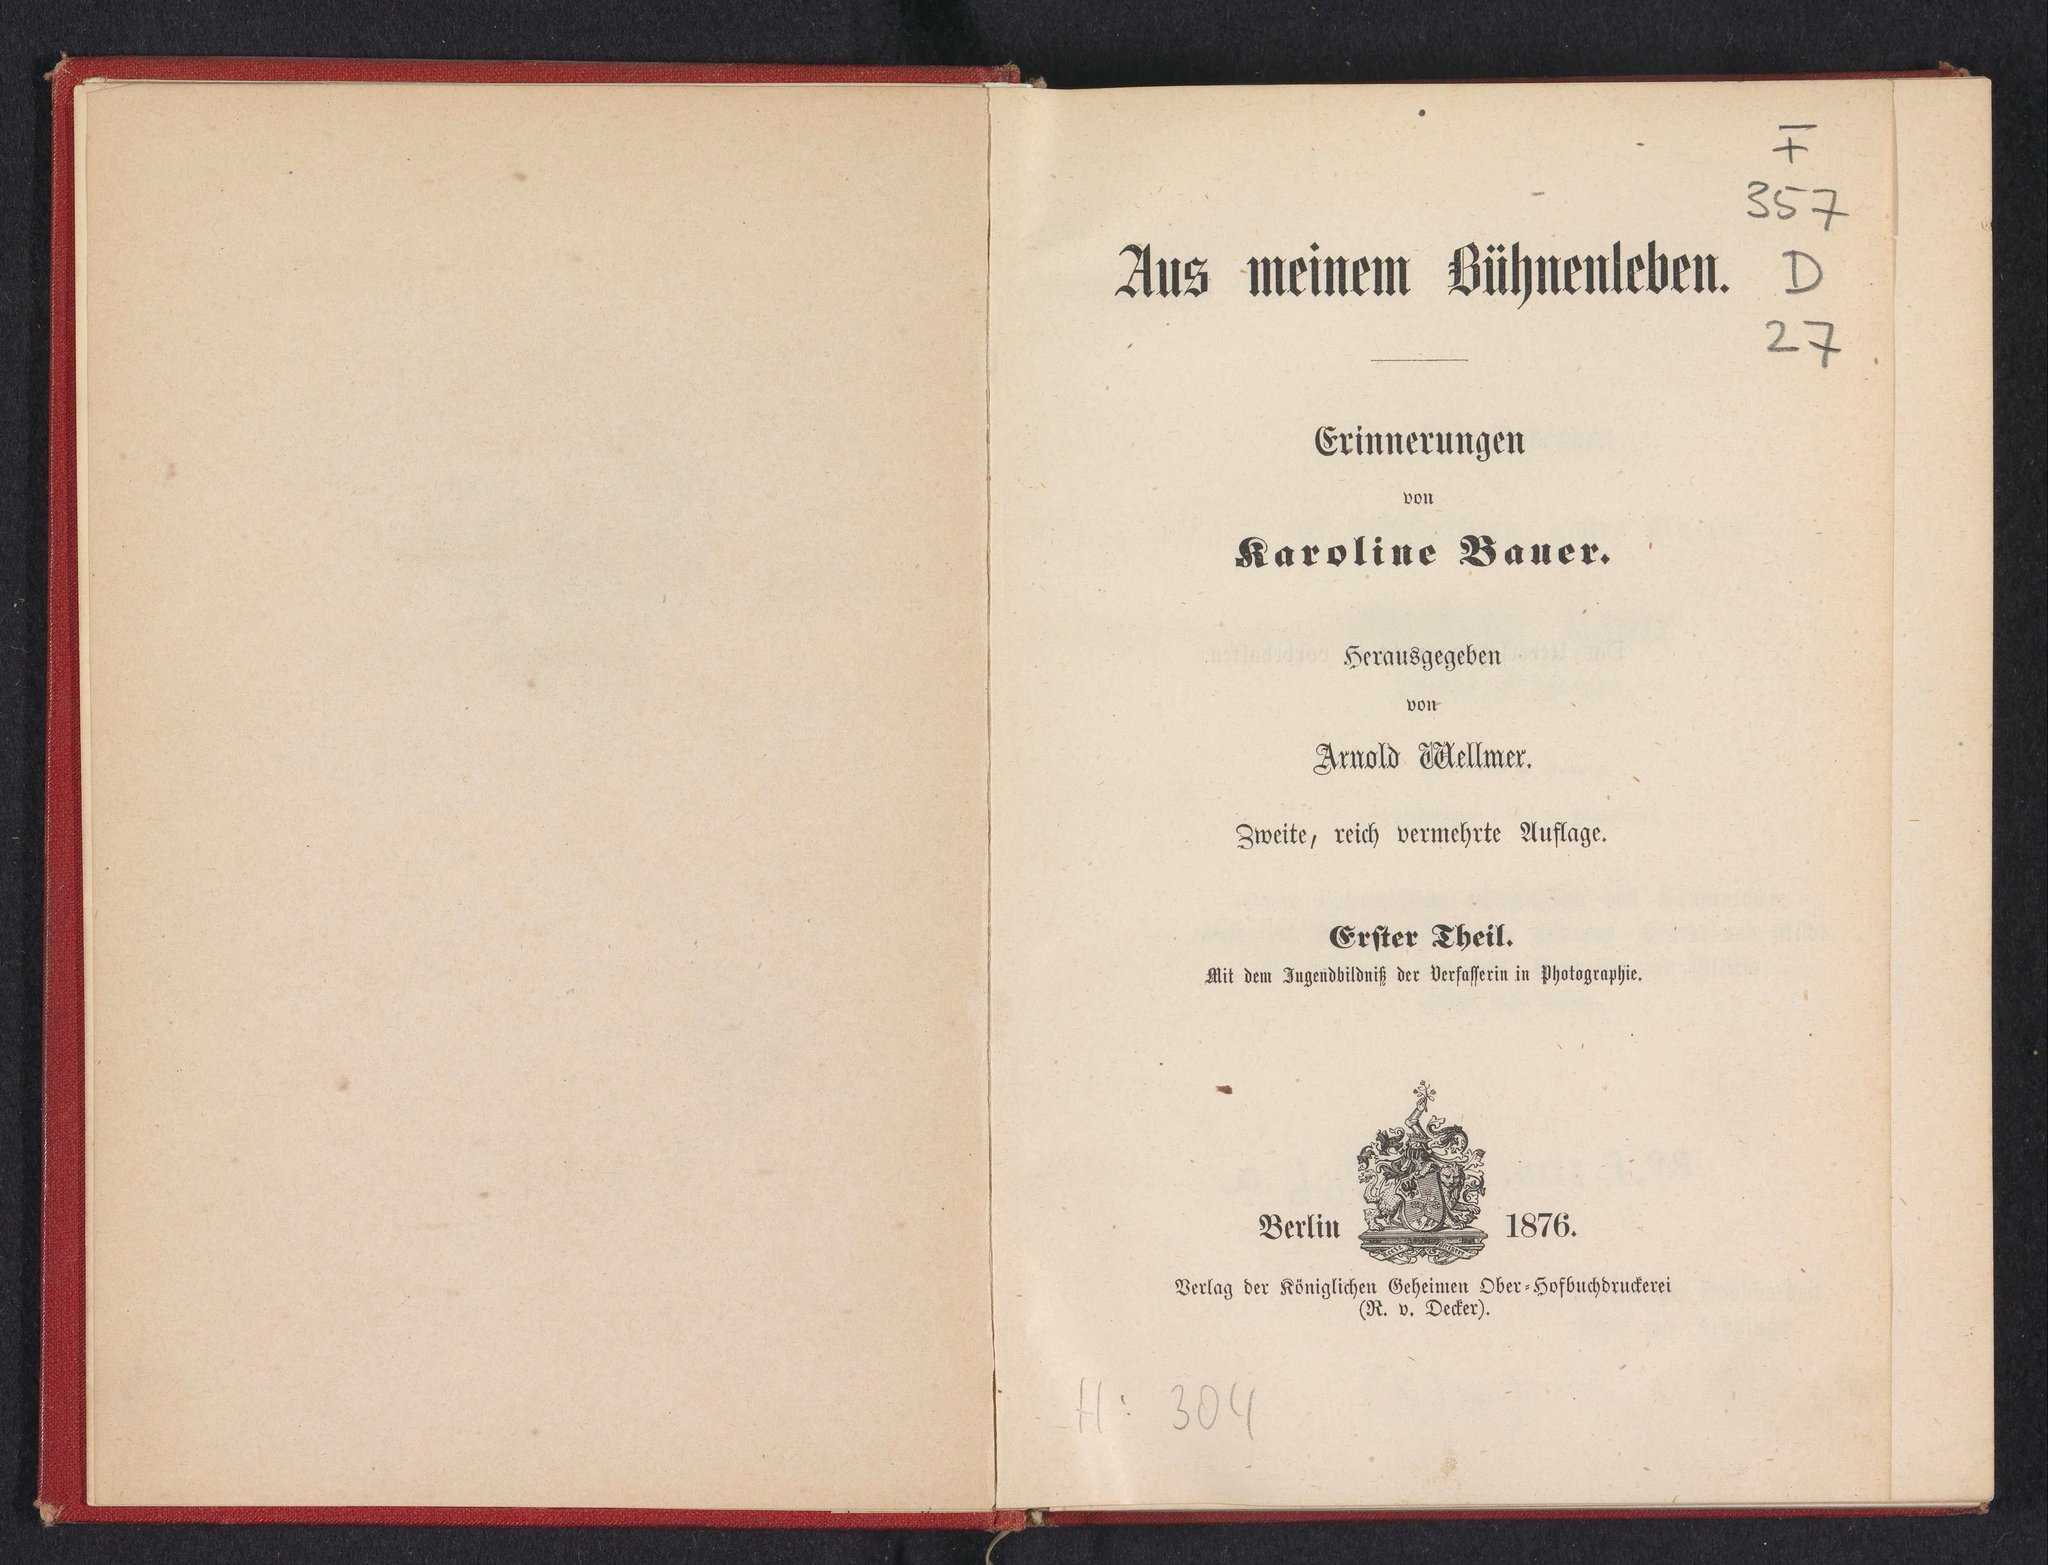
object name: book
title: Aus meinem Bühnenleben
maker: arnold wellmer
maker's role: schrijver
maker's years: 1835-1915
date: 1876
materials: cardboard, linen, paper, photographic support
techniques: salted paper print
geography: berlin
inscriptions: name: ‘R. Voigtländer's Sortiments-Buchhandlung (G. Barth) Kreuznach’